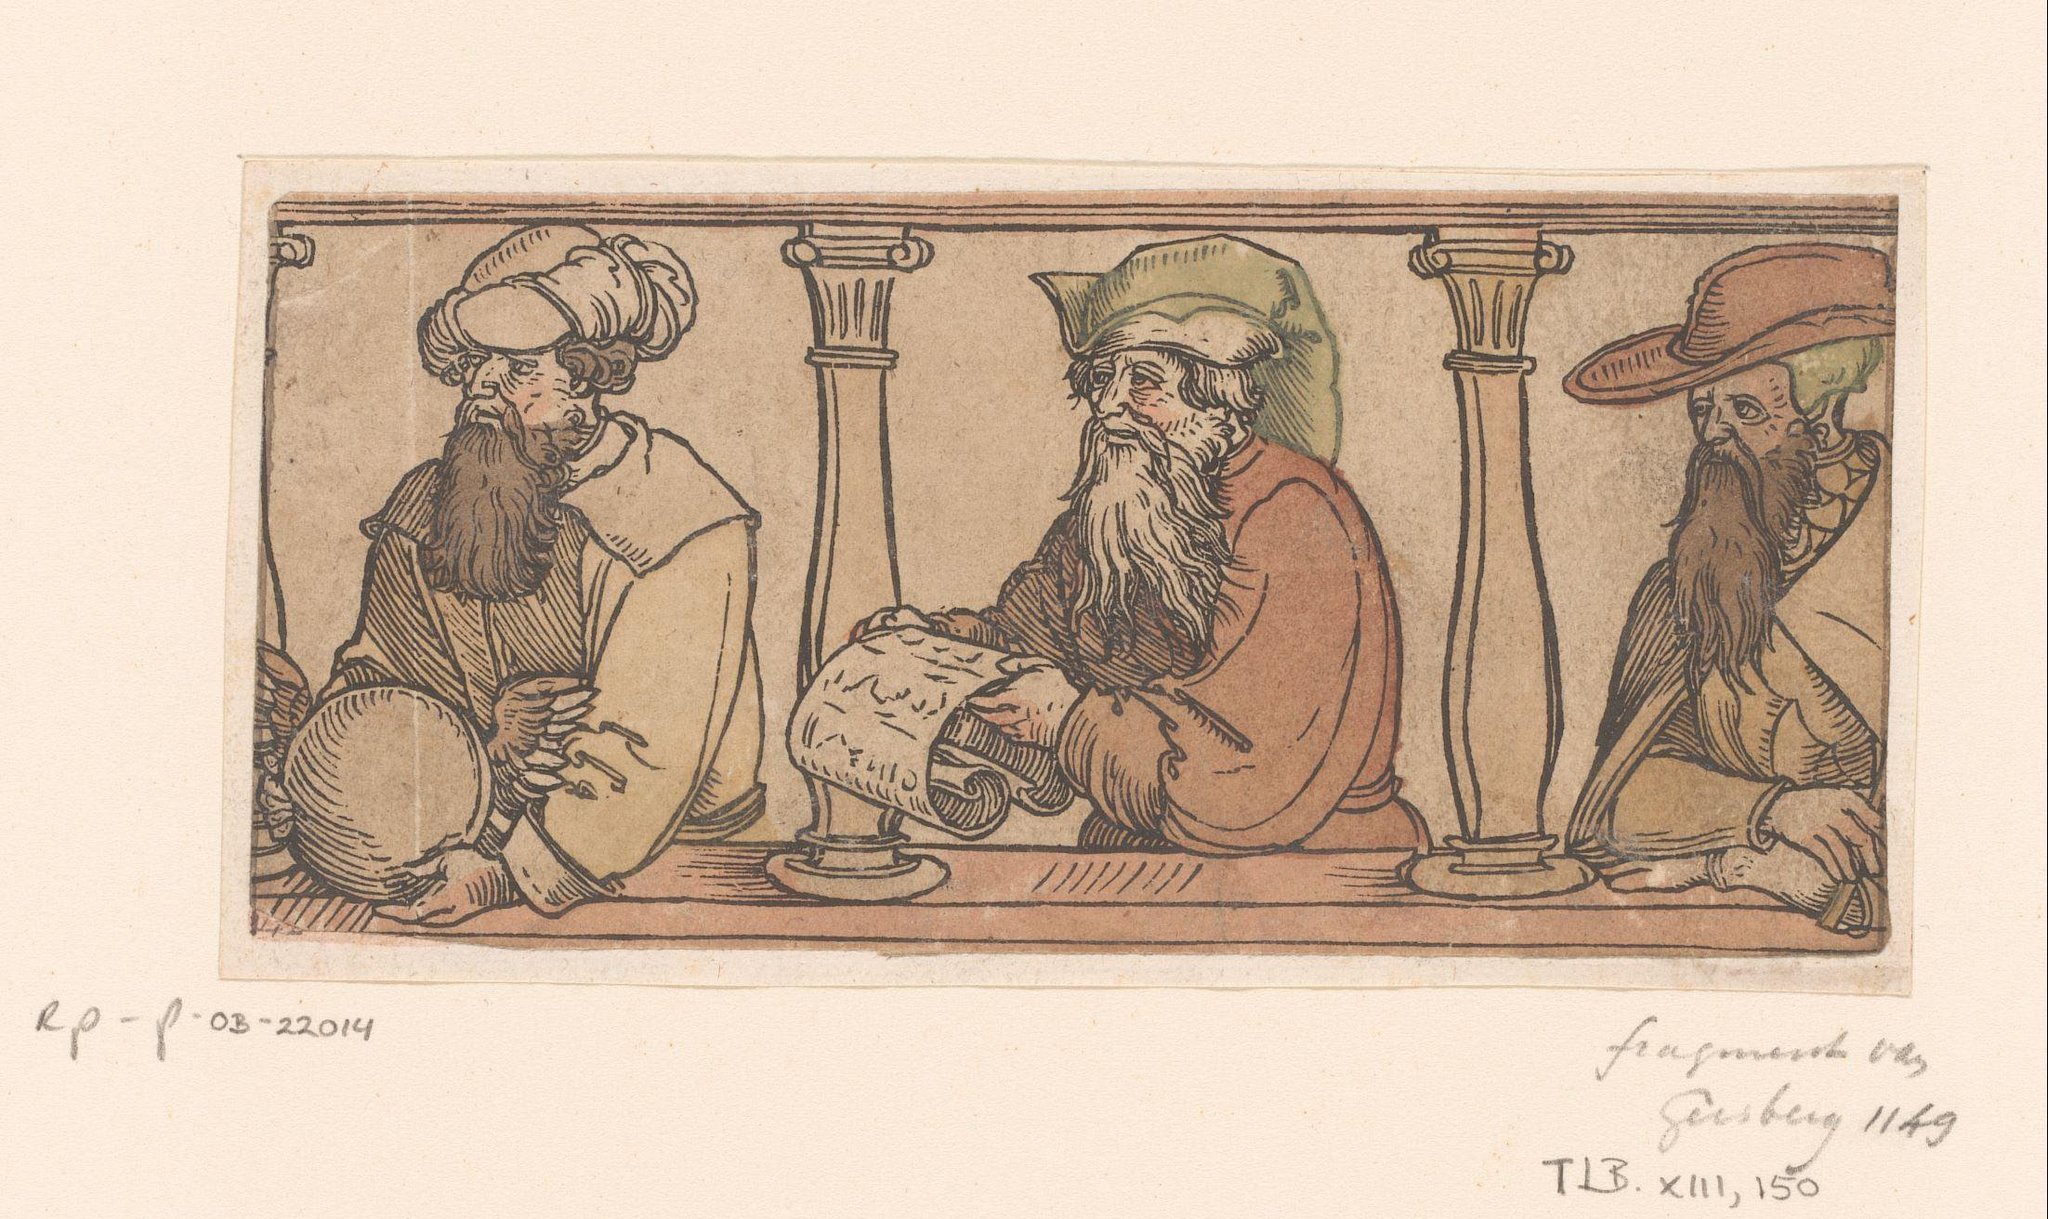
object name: print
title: Fragment van een fries met de Zeven Wijzen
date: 1532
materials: paper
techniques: hand coloring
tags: the seven wise men of greece: bias, chilon, cleobulus, periander (alternatively myson), pittacus, solon, thales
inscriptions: collector's mark: Lugt 240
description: Fragment van een geheel waar alle Zeven Wijzen op staan. Waarschijnlijk gemaakt ter illustratie van een gedicht van Hans Sachs uit 1532: Die siben alten haidenischen weysen.